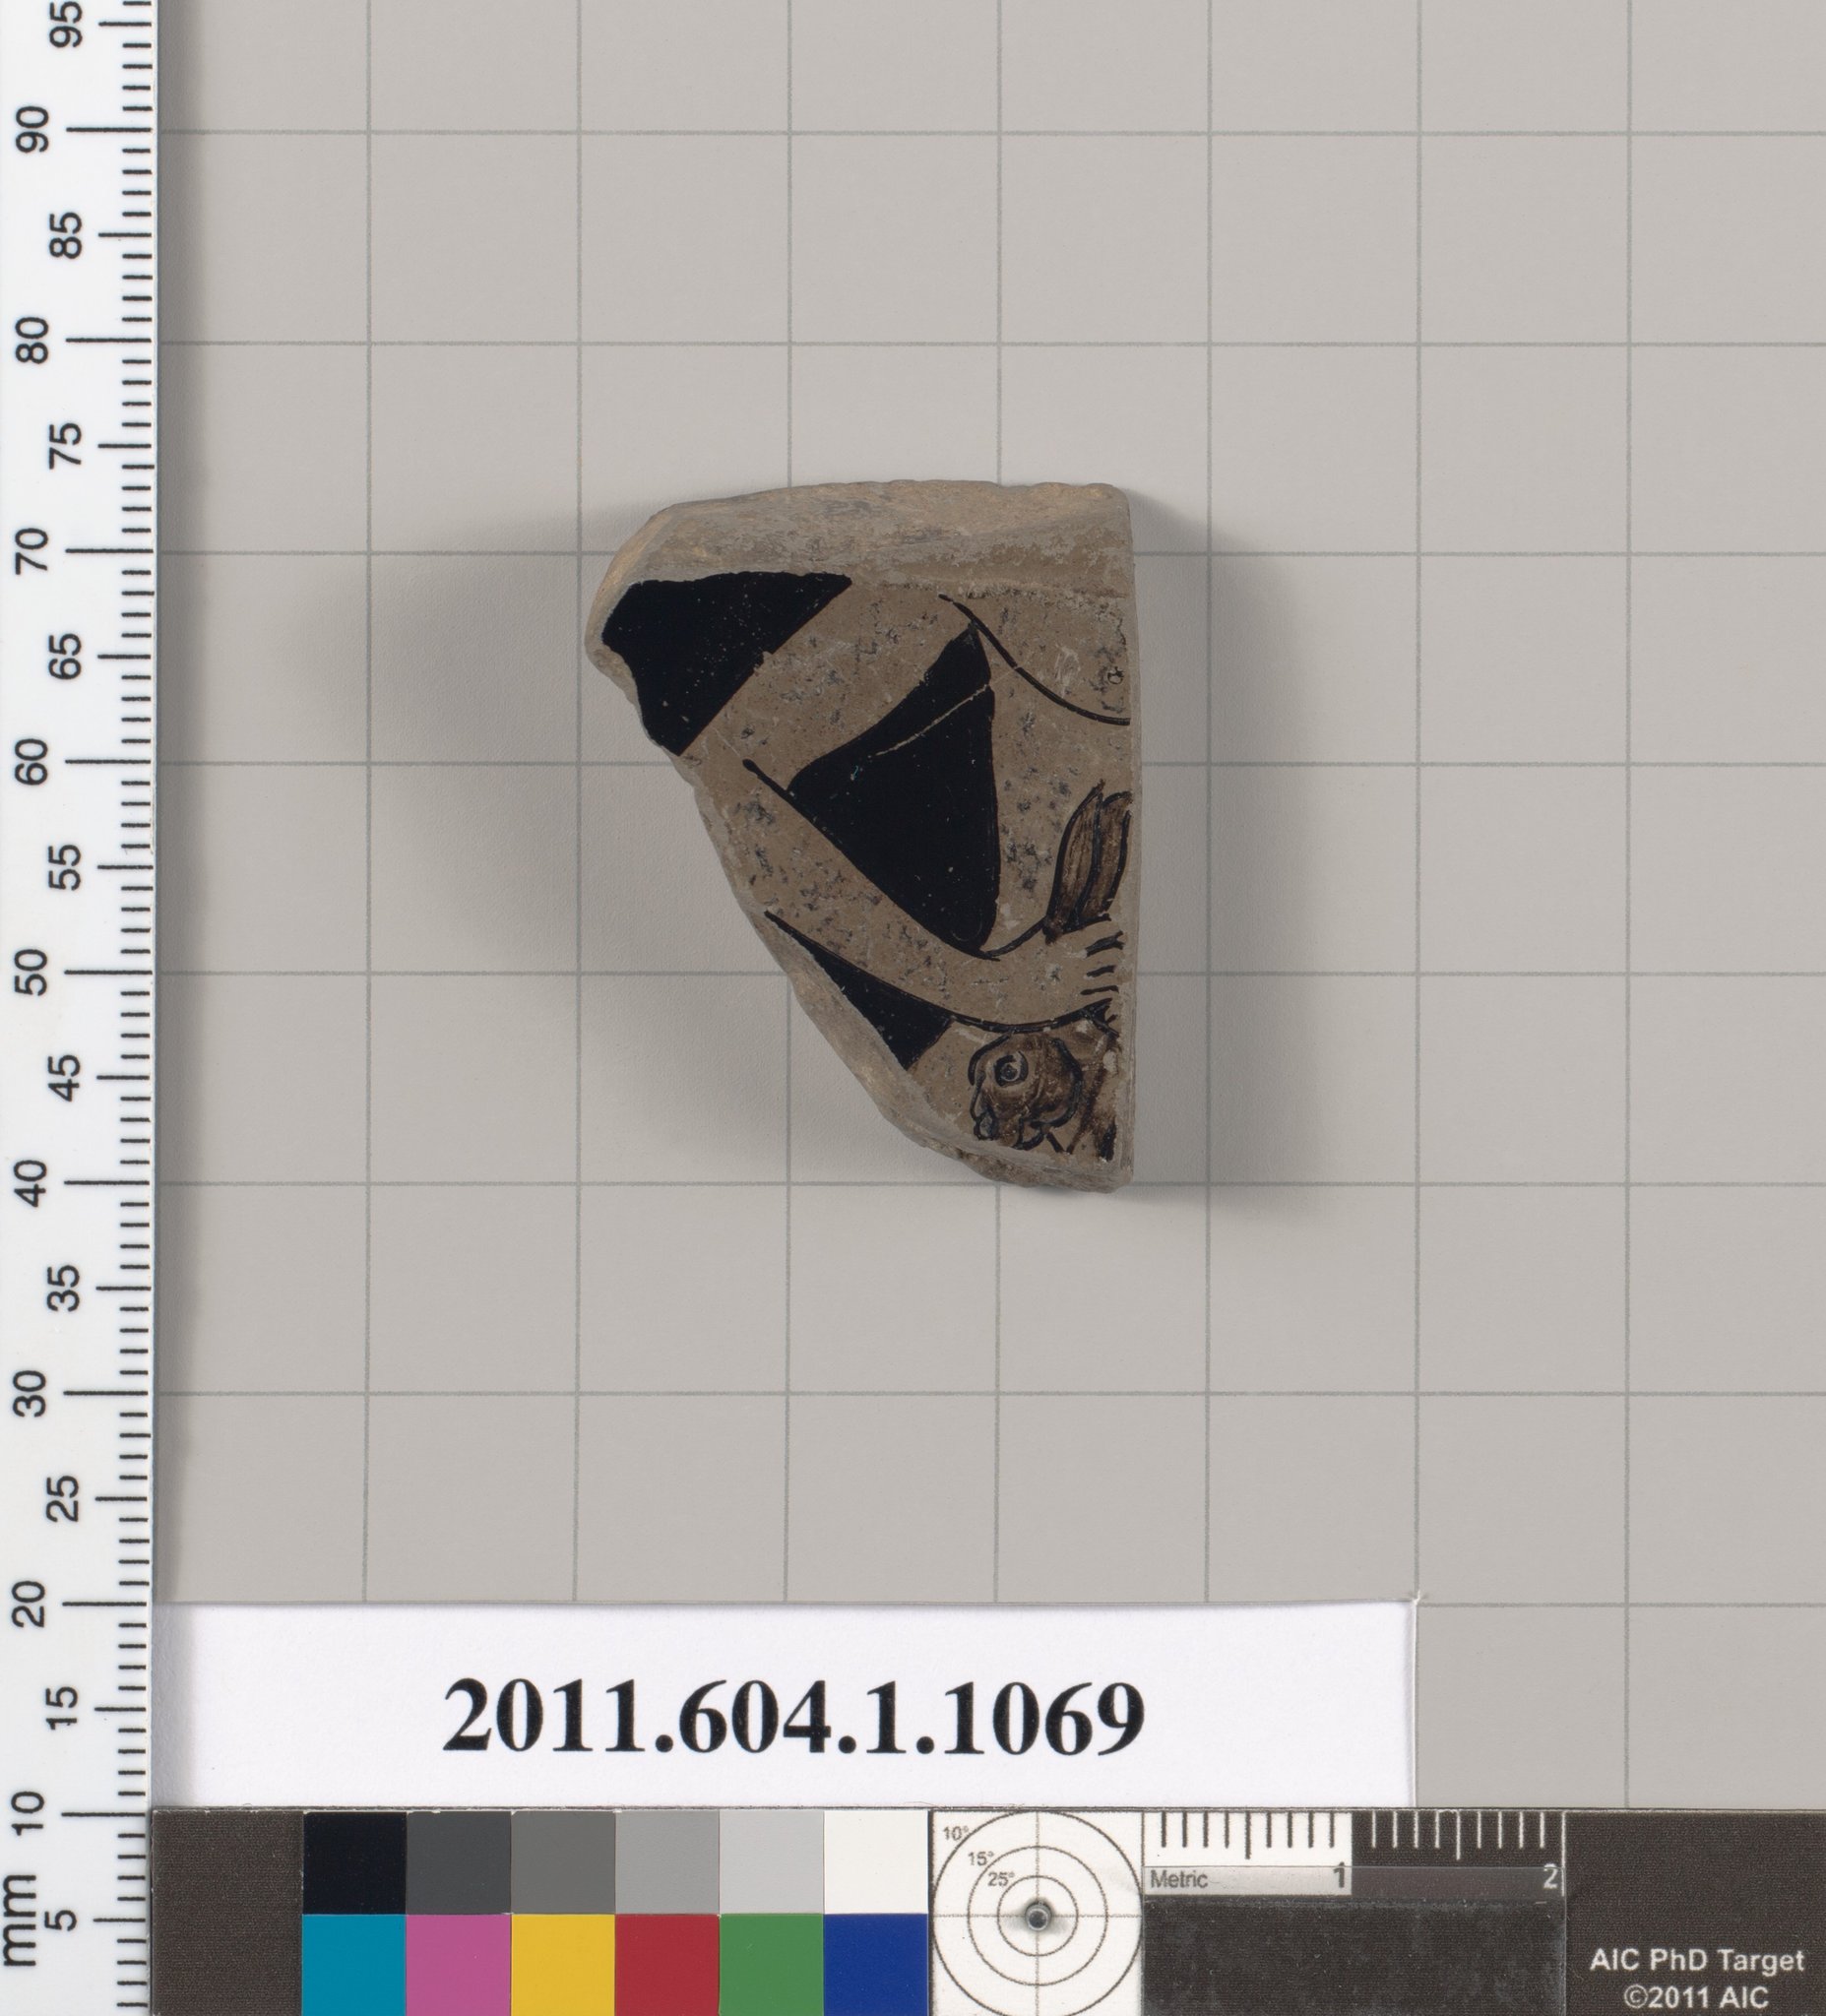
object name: kylix fragment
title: Terracotta fragment of a kylix (drinking cup)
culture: greek, attic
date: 490-480 BCE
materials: terracotta